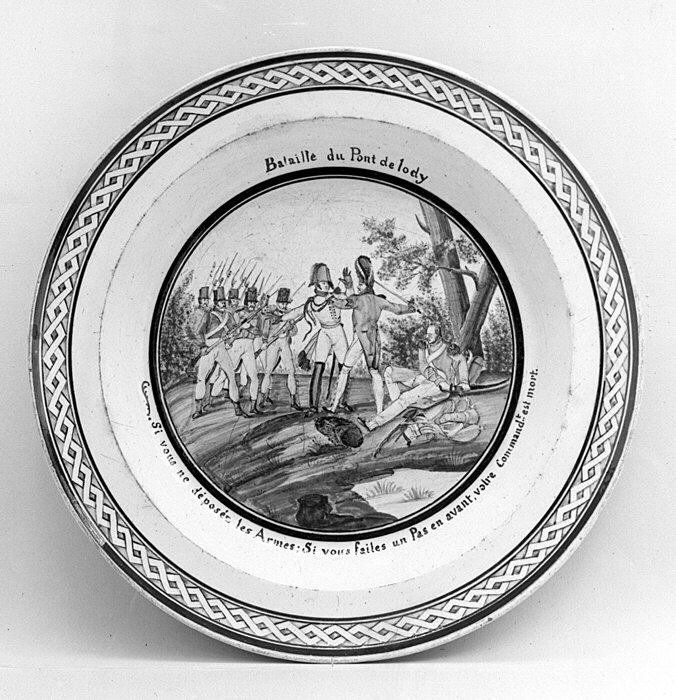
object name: plate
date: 1820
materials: faience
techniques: glazing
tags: soldiers